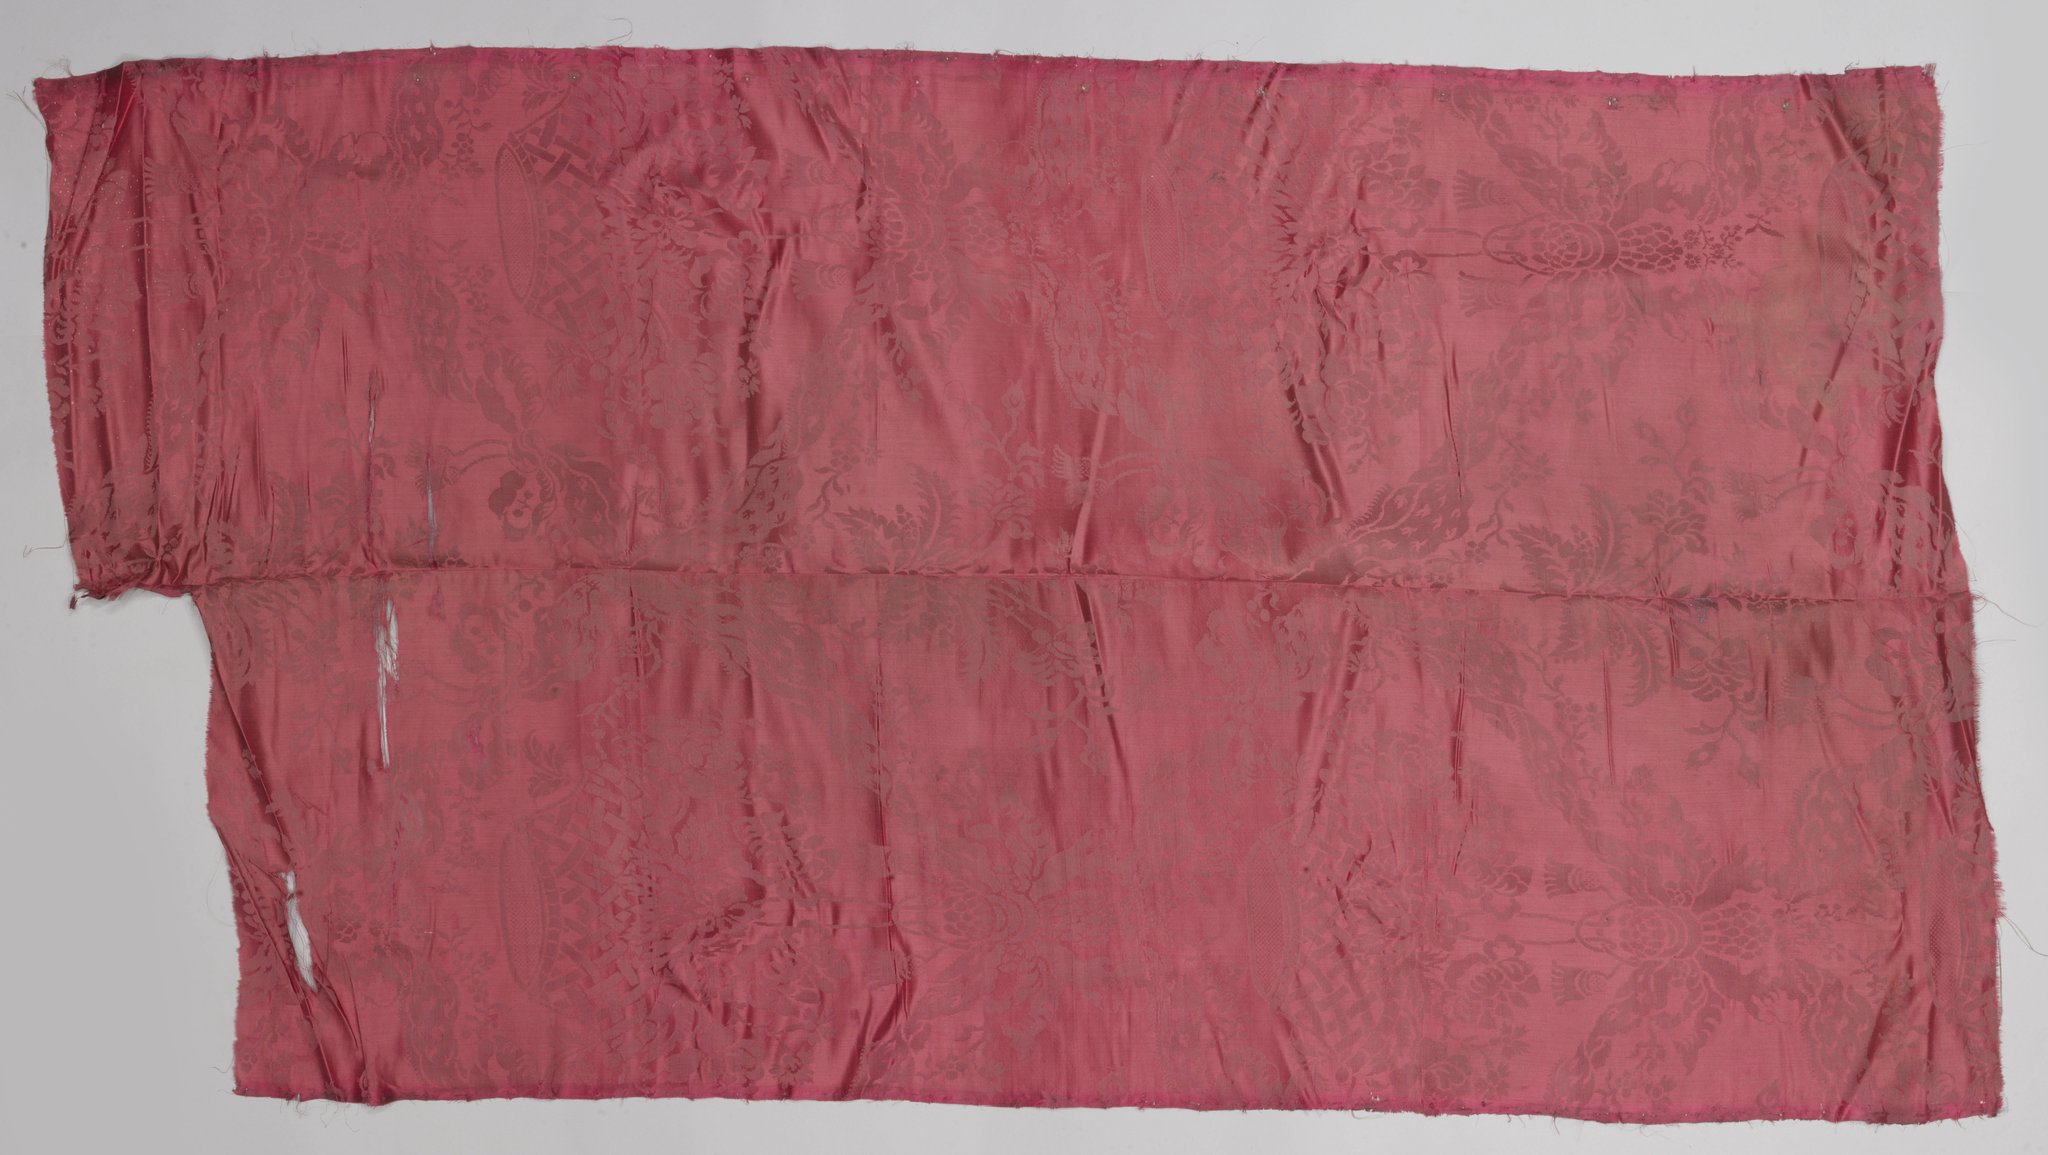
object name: woven material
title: Zijdedamast in wijnrood met een patroon van een ruitindeling door hermelijn-draperieën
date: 1800-1900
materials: silk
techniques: damask, weave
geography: france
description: Zijdedamast in wijnrood met een patroon van een ruitindeling door hermelijn-draperieën, driemaal gestrikt en met afhangende kwasten en met in het midden een mand rozen. De zijdedamast is afkomstig uit het Paleis op de Dam.